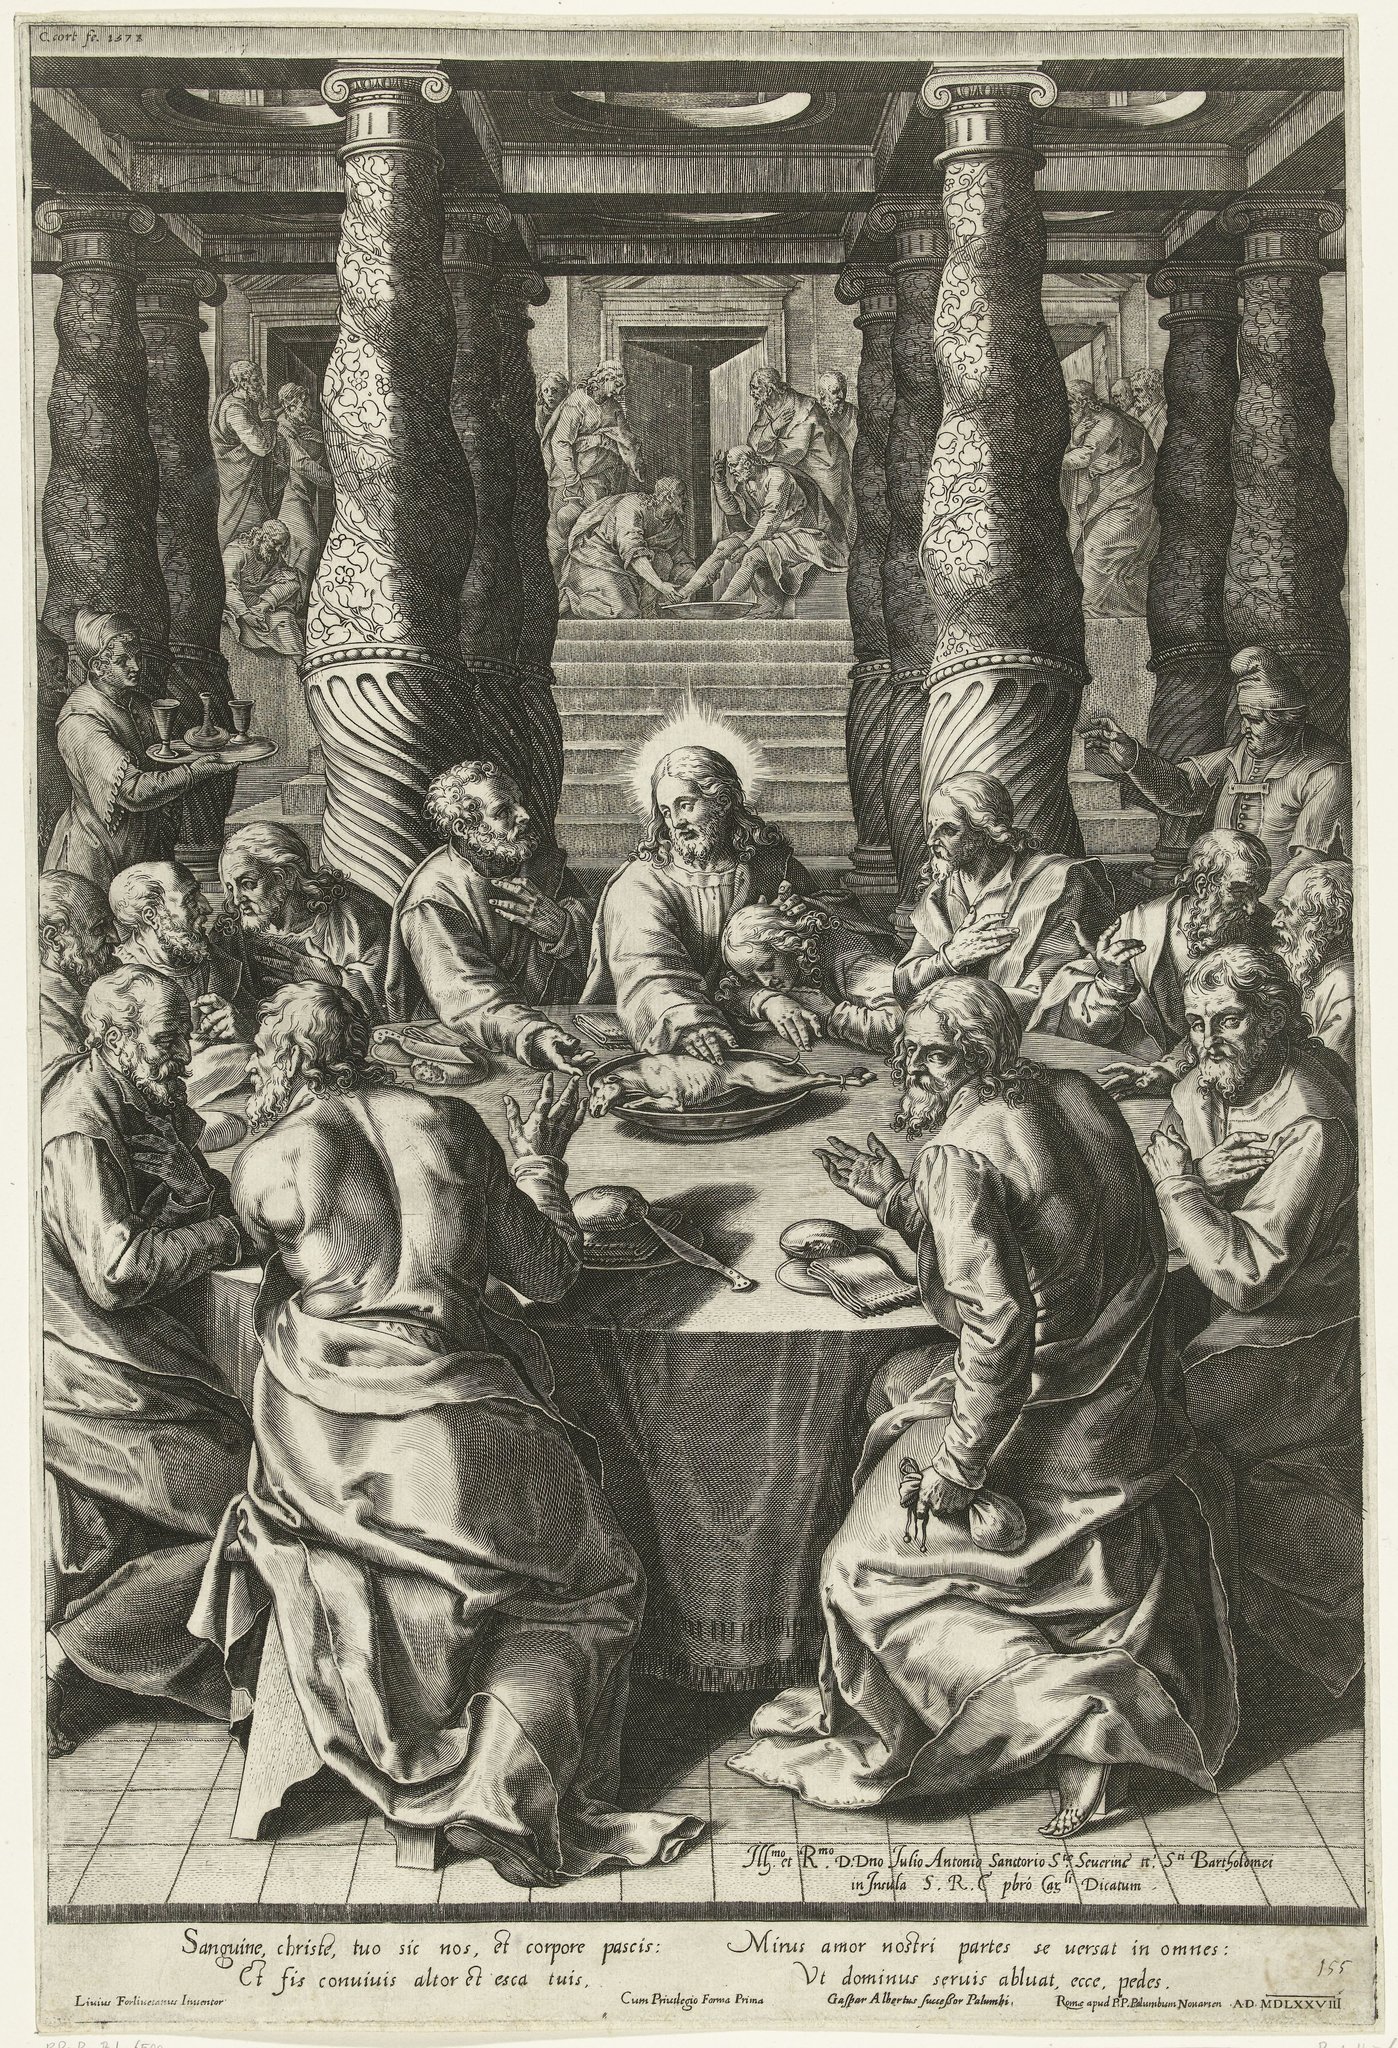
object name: print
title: Laatste avondmaal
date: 1578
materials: paper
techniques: engraving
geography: rome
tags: christ washes the feet of the apostles (john 13:1-20), last supper (in general) (matthew 26:21-35; mark 14:18-31; luke 22:3, 22:15-23; john 13:21-38)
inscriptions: date: ‘1578’, caption: ‘Sanguine, christe, tuo sic nos, et corpore pascis: / Et fis convivis altor est et esca tuis // Minis amor nostri partes se versat in omnes: / Ut dominus servis ablvat, ecce pedes.’, dedication: ‘Ill. mo et R.mo D. Dno Julio Antonio Sanctorio S.tae Severinae tt. S.ti. Bartholomei / in Insula S.R.C. pbro Car. li Dicatum’, signature: ‘C. cort fe.’, collector's mark: Lugt 240, address: ‘Gaspar Albertus successor Palumbi’, address: ‘Romae apud P.P. Palumbus Novarien A.D. MDLXXVIII’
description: In een ruimte met gedraaide zuilen zit Christus met zijn apostelen aan een ronde tafel aan het laatste avondmaal. Op tafel een schaal met een lam. Johannes zit rechts naast Christus, zijn hoofd op de handen. Rechtsvoor Judas met een beurs in zijn hand. Op de achtergrond tussen de zuilenrij door is de voetwassing te zien.